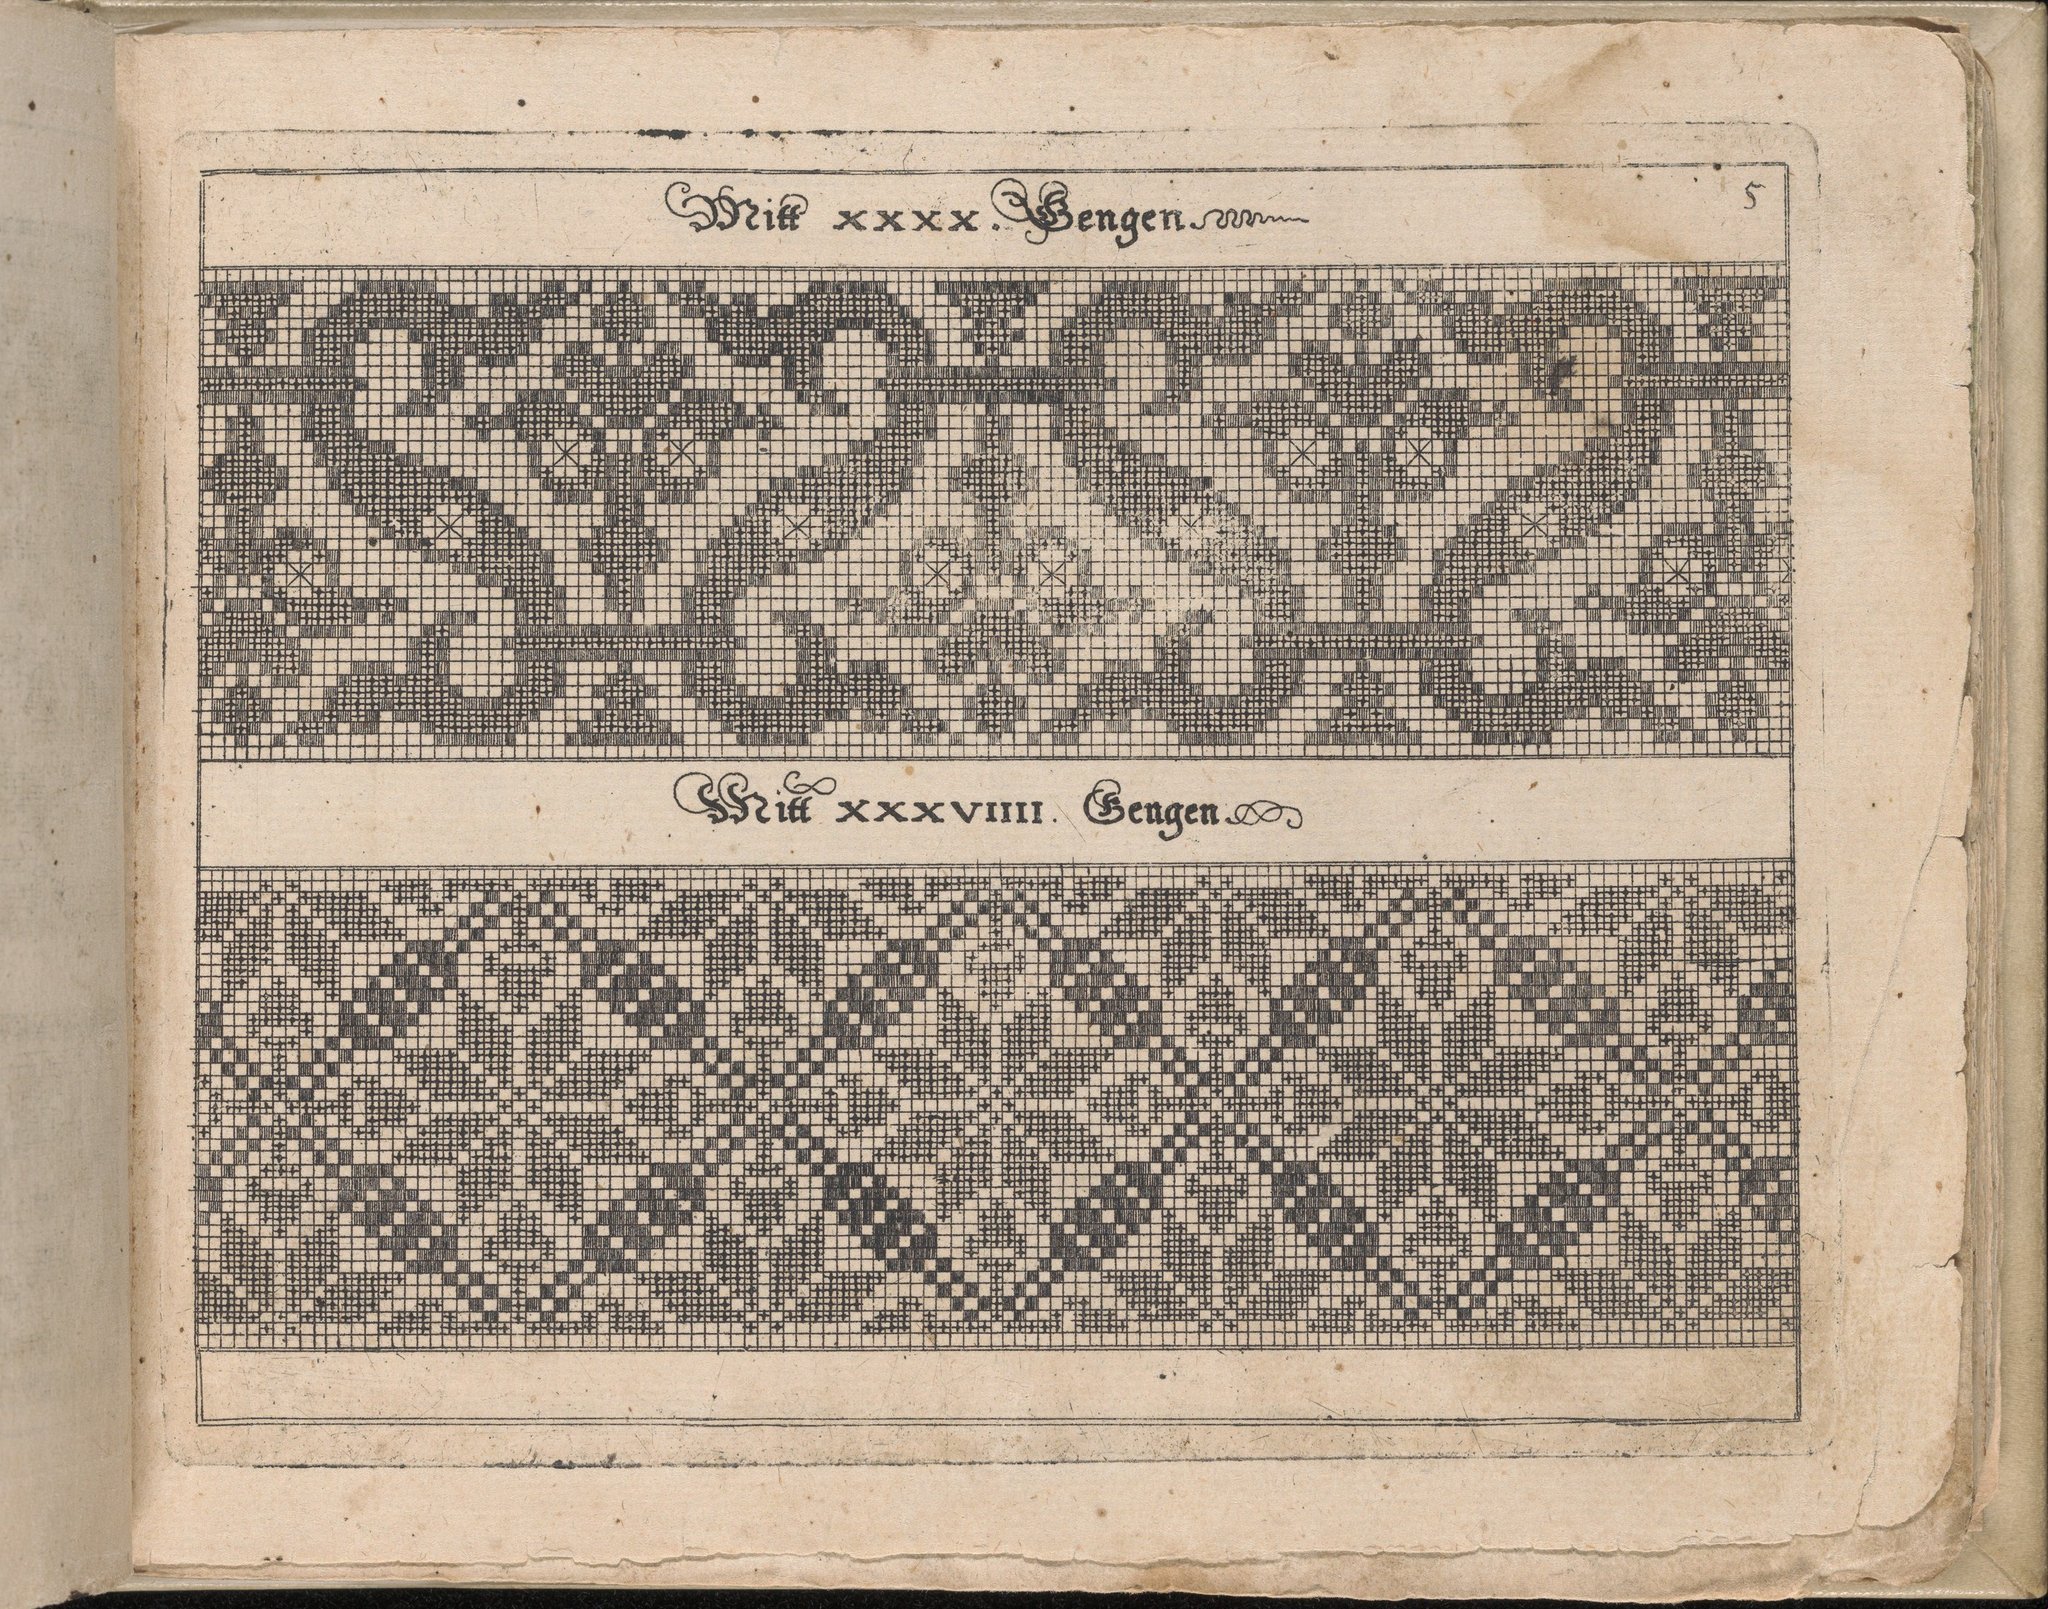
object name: book print ornament architecture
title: Schön Neues Modelbuch (Page 10 recto)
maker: johann sibmacher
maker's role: designer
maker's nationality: german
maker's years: 1590-1611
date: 1597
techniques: etching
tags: flowers